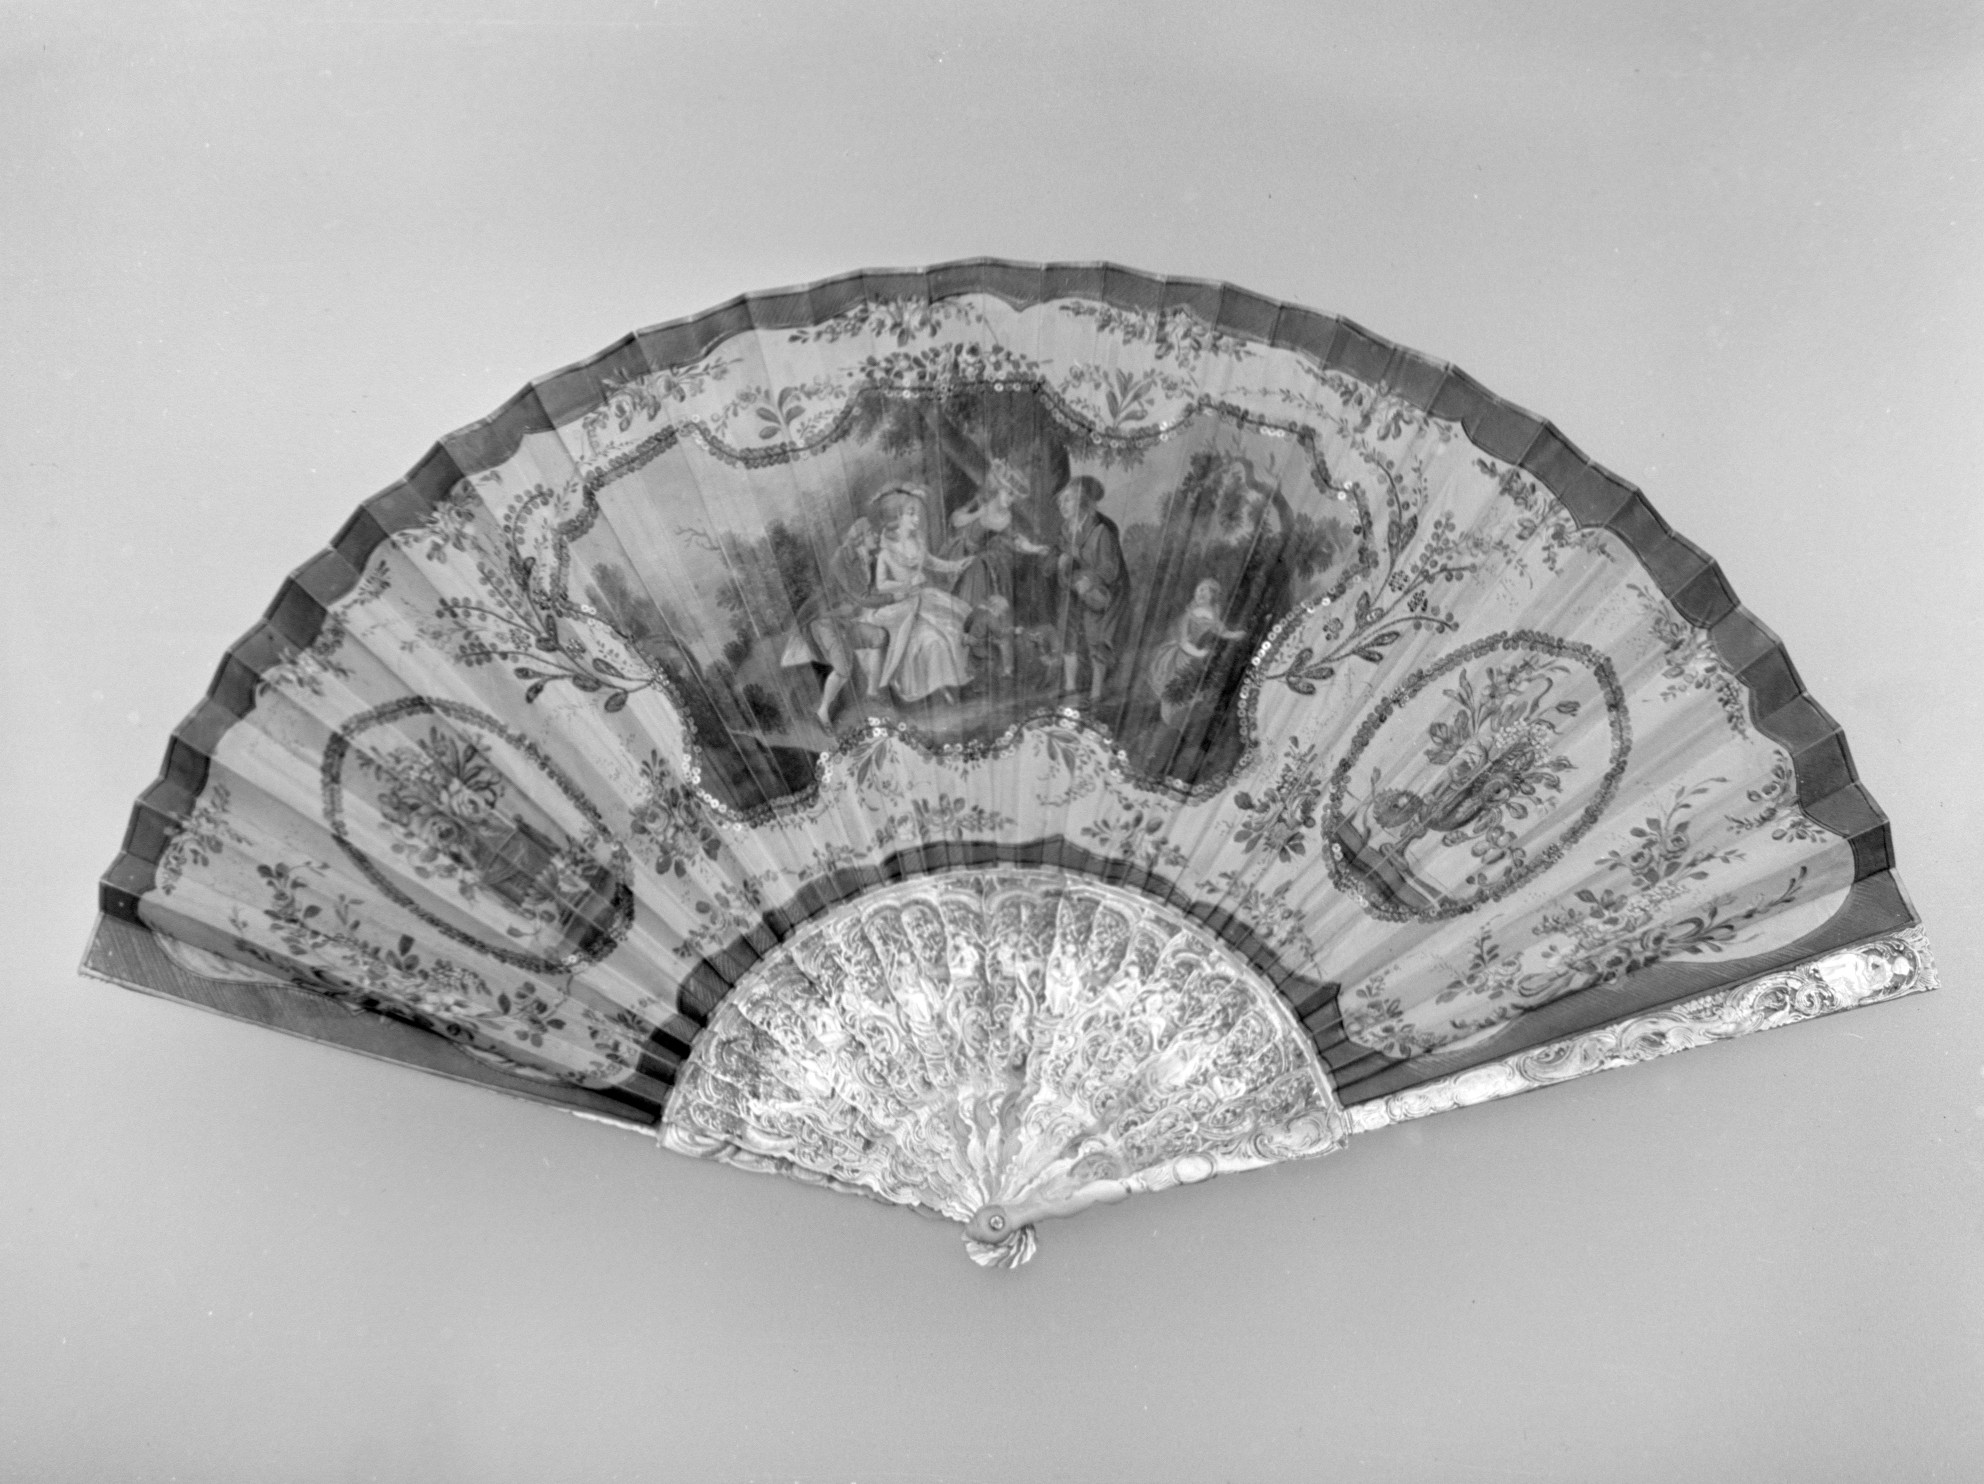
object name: fan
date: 1876-1900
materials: glass, mother of pearl, paper, silk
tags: men,women,flowers